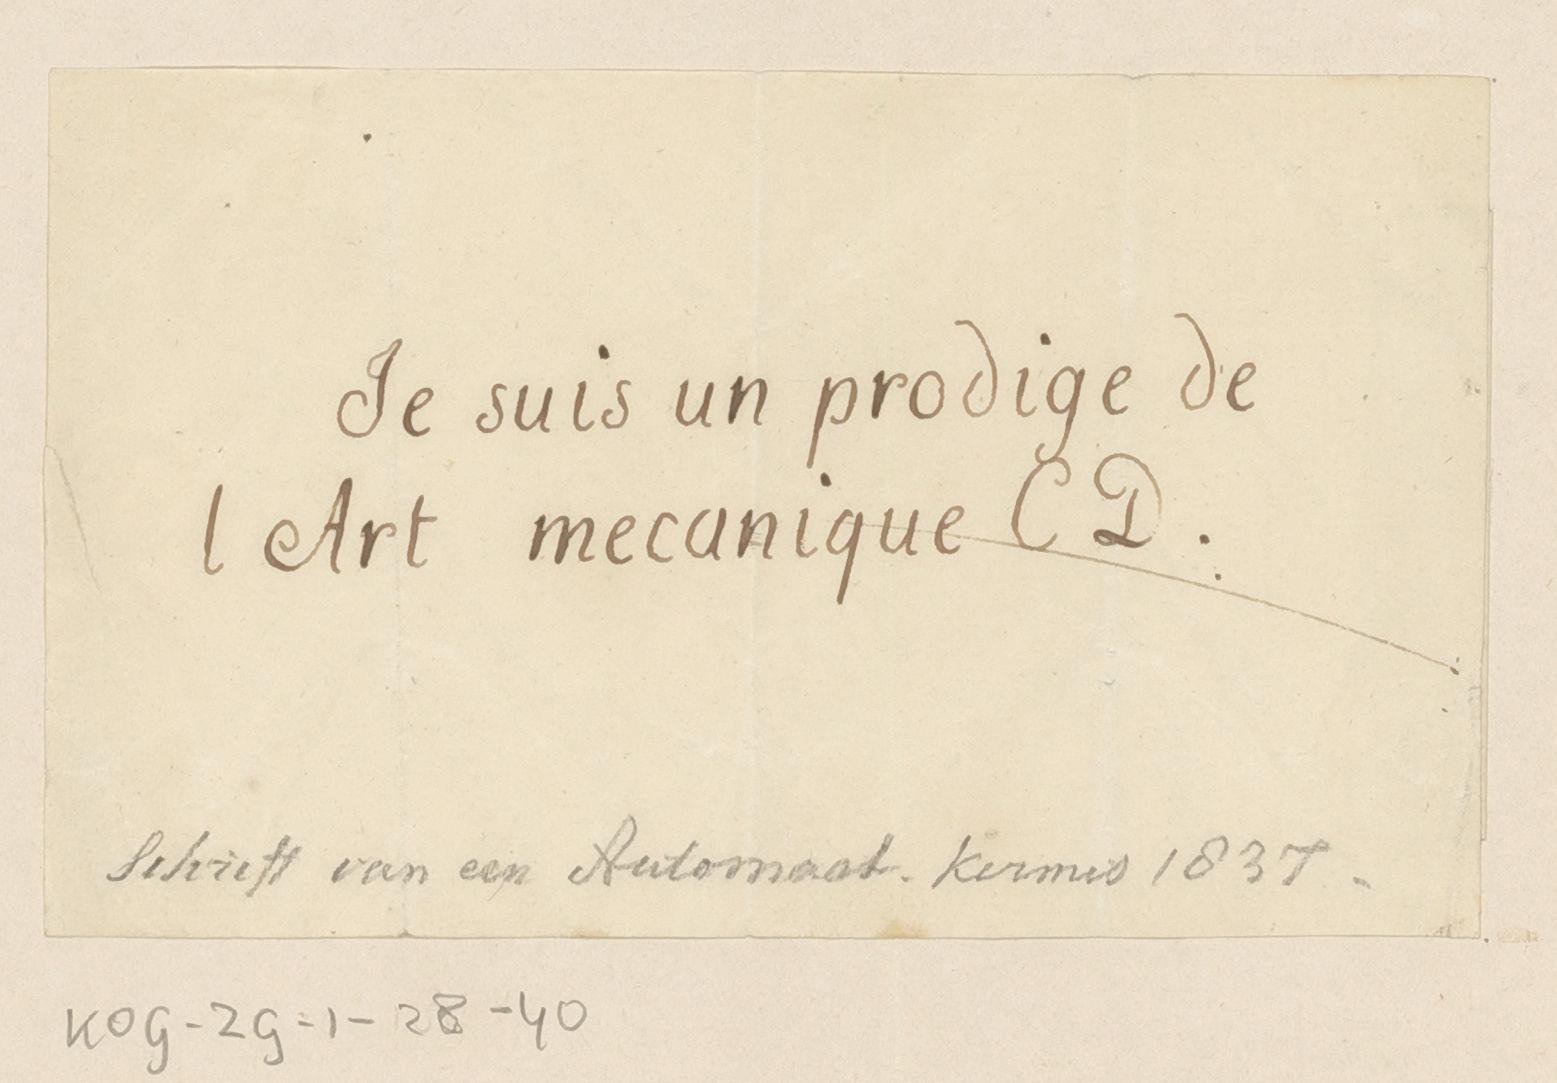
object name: manuscript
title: Tekst geschreven door een automaat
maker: Anonymous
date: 1837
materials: ink, paper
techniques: pen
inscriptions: stamp, stamp, collector's mark: Lugt 1641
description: Onderwerpsrubrieken binnen de Atlas Zeden en Gewoonten: Zeden en Gewoonten in Engeren Zin. Volksleven. Volksfeesten. Kermistypen, wondermenschen en dergelijken.